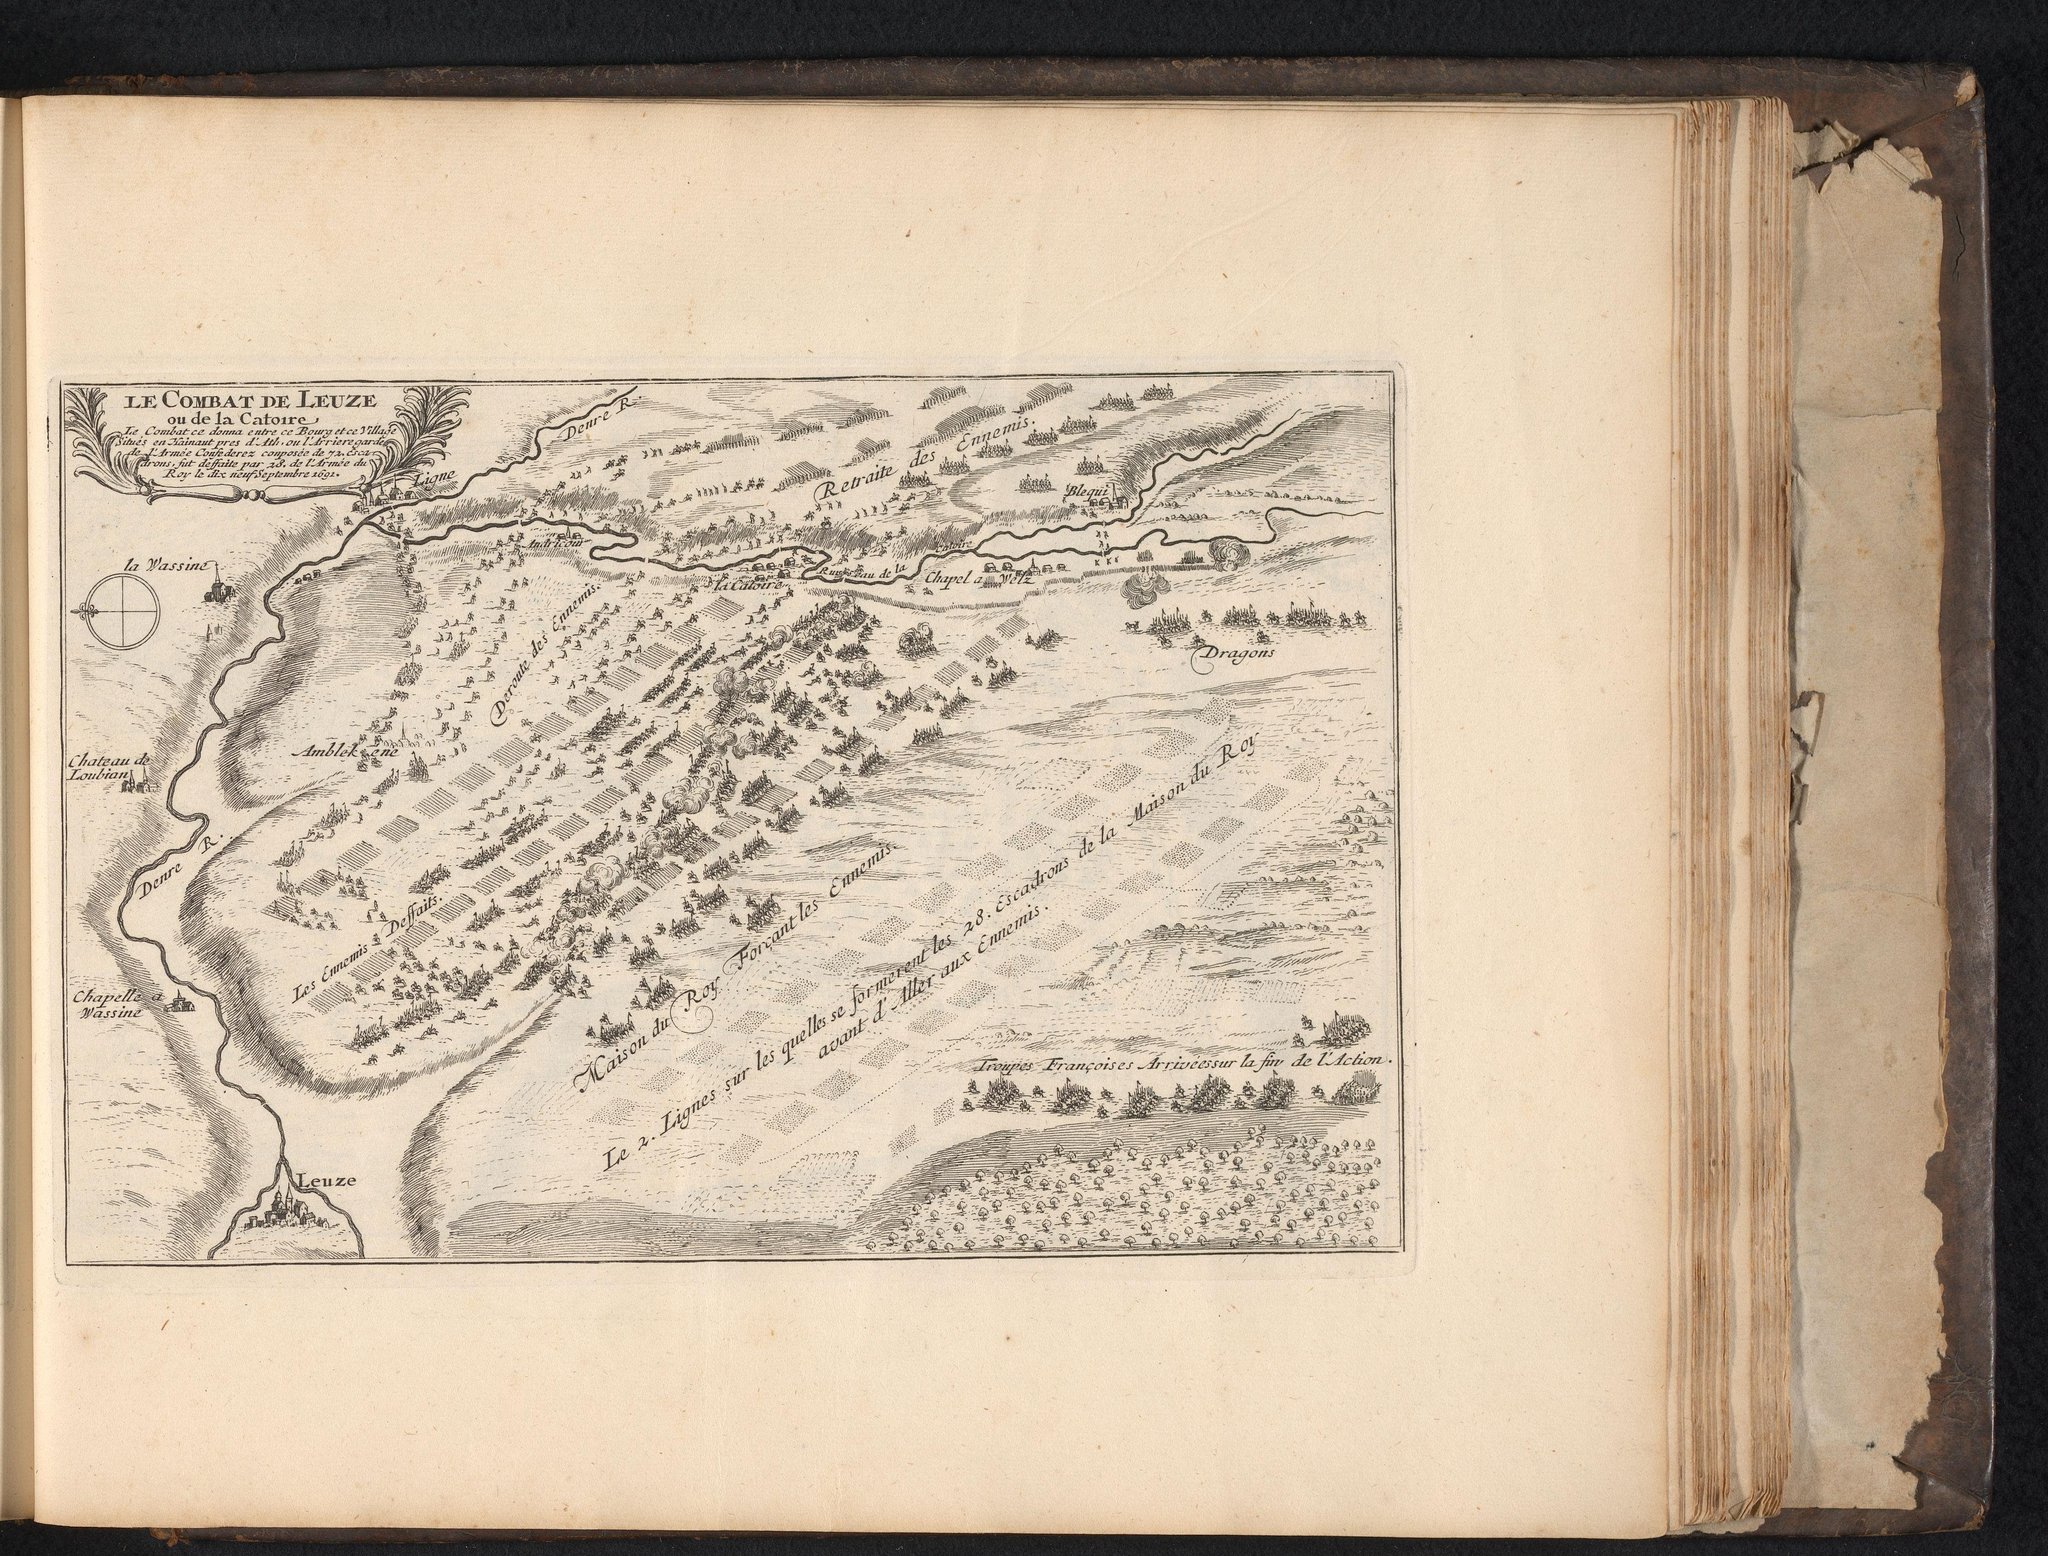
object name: map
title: Le Combat de Leuze ou de la Catoire (...) ou l'Arriere garde de l'Armée Confederez (...) fut deffaite par 28. de l'Armée du Roy le dix neuf Septembre 1691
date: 1693-1696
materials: paper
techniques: etching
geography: paris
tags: maps of separate countries or regions, battle (+ land forces)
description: Plan van de slag bij Leuze waar de geallieerden door het Franse leger verslagen worden, 19 september 1691. Onderdeel van het eerste van twee delen van het prentwerk: Le Theatre de la Guerre, dans les Pays-Bas, waarvan het titelblad uitgegeven is in 1696. Het prentwerk bestaat in totaal (beide delen) uit 52 platen met plannen (afkomstig van Sébastien Le Prestre, Seigneur de Vauban) van vermaarde sterke steden en vestingen in de Negenjarige Oorlog in de Nederlanden. Identiek aan de plaat die voorkomt in: Les forces de l'Europe, uitgegeven tussen 1693-1697. Titel en opschriften in het Frans.